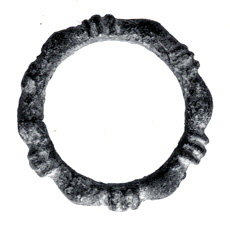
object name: ring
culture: middle niger civilization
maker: middle niger artist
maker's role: artist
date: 1200-1700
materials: bronze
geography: mali